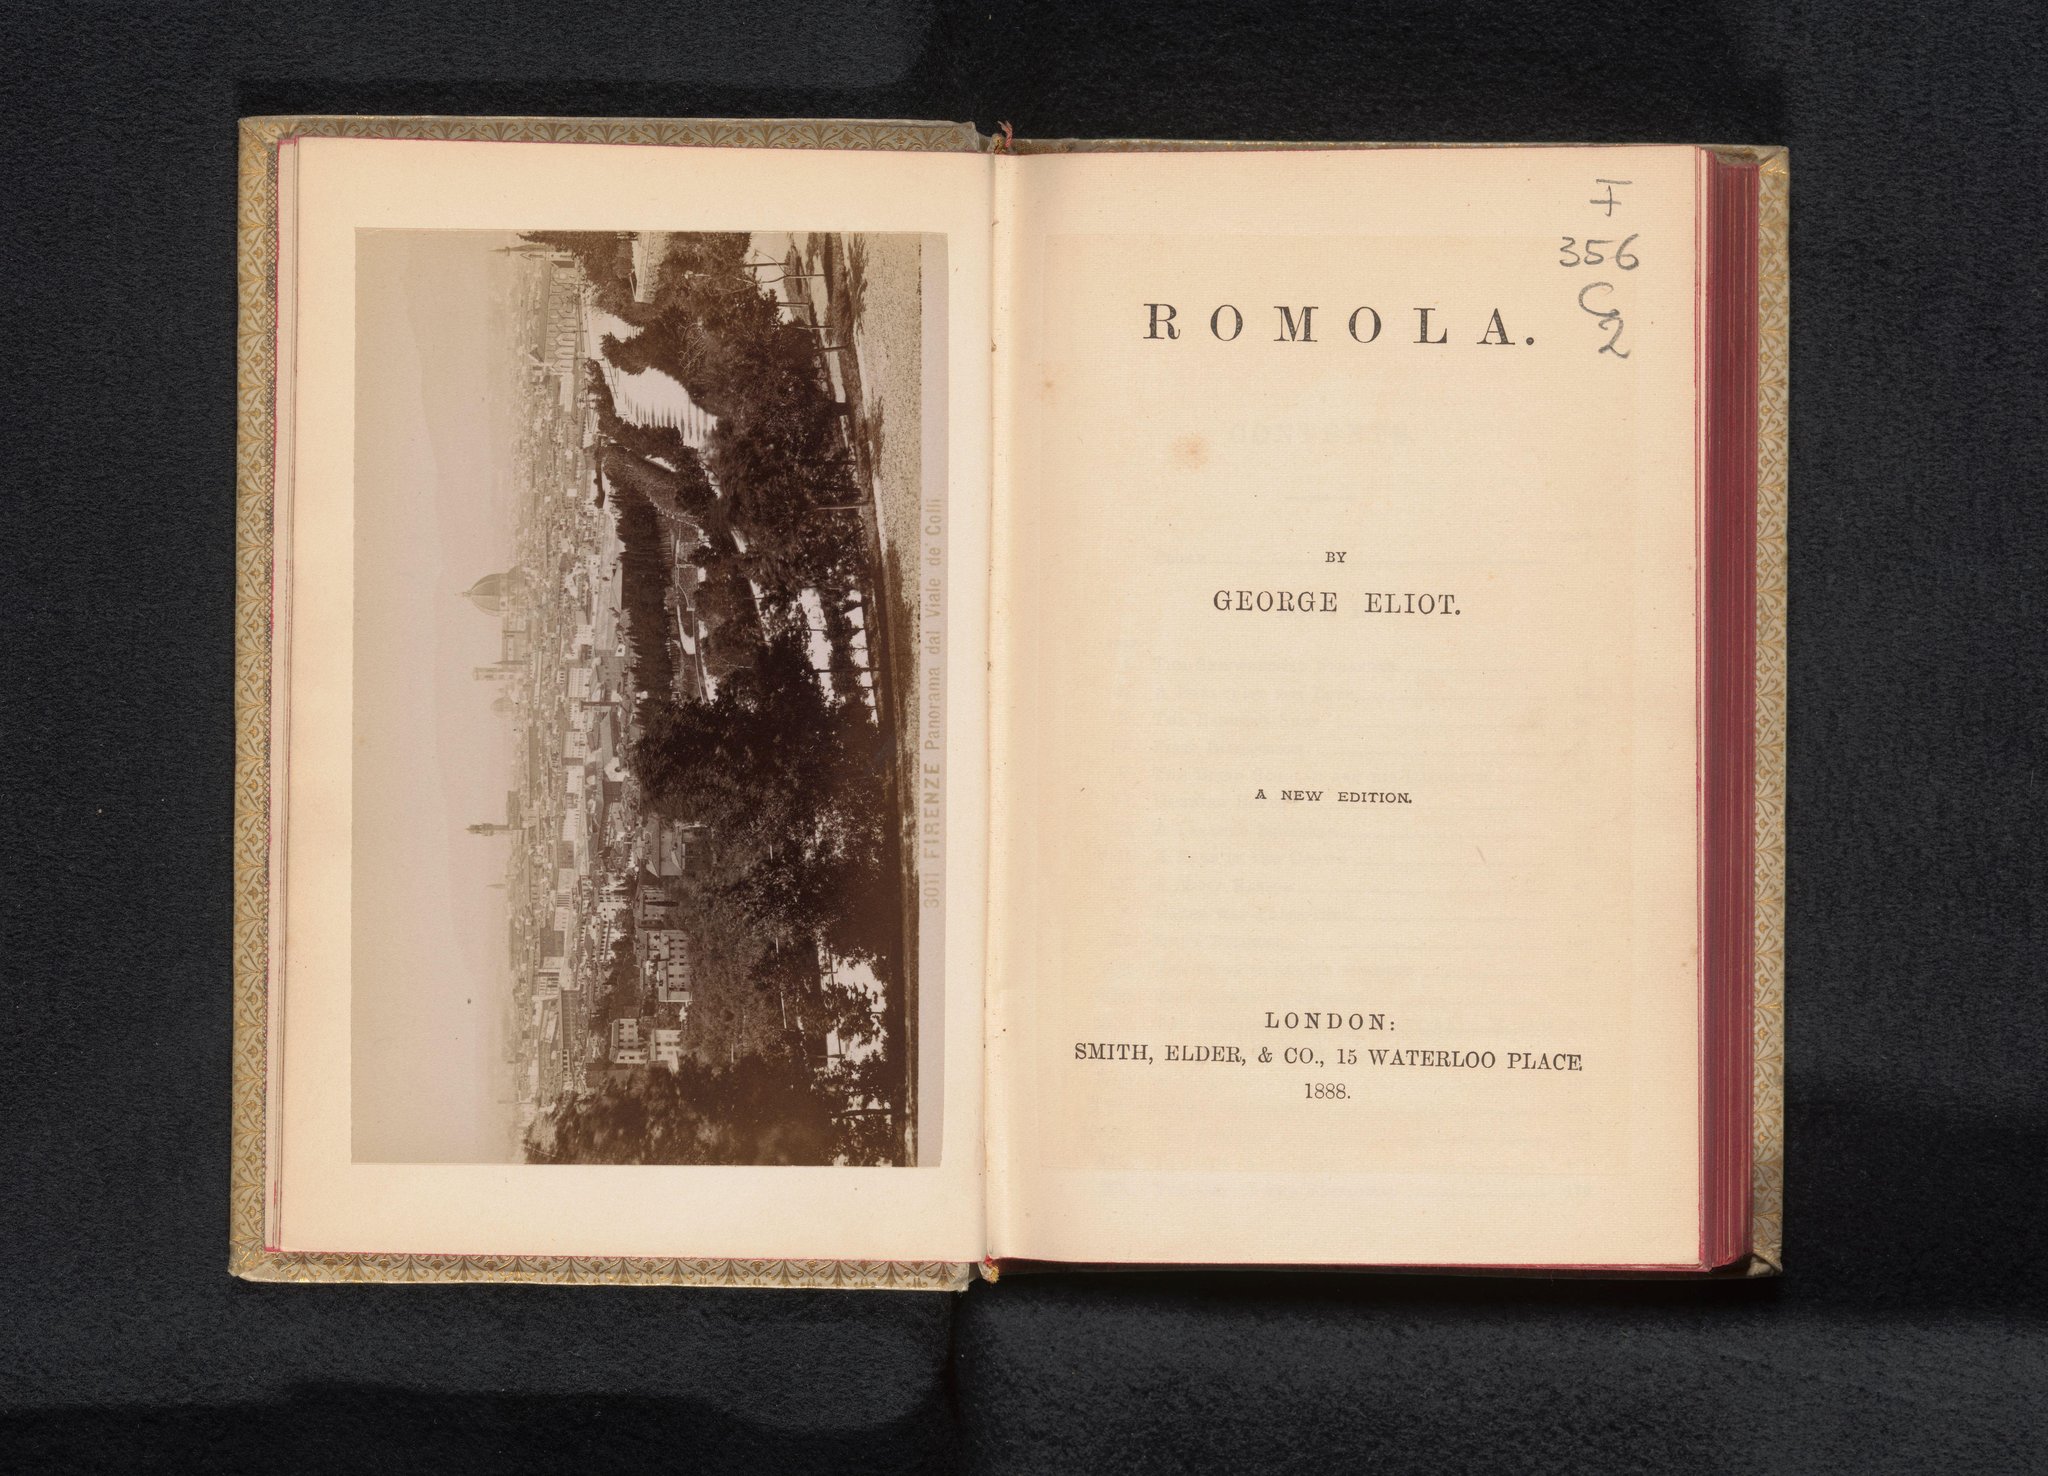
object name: book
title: Romola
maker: george eliot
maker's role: schrijver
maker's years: 1819-1880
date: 1888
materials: cardboard, paper, photographic support, parchment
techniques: albumen print, printing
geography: london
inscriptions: inscription: ‘Gertrude from Papa. Florence. 17 March 1893.’, inscription: ‘ex libris SFJ’